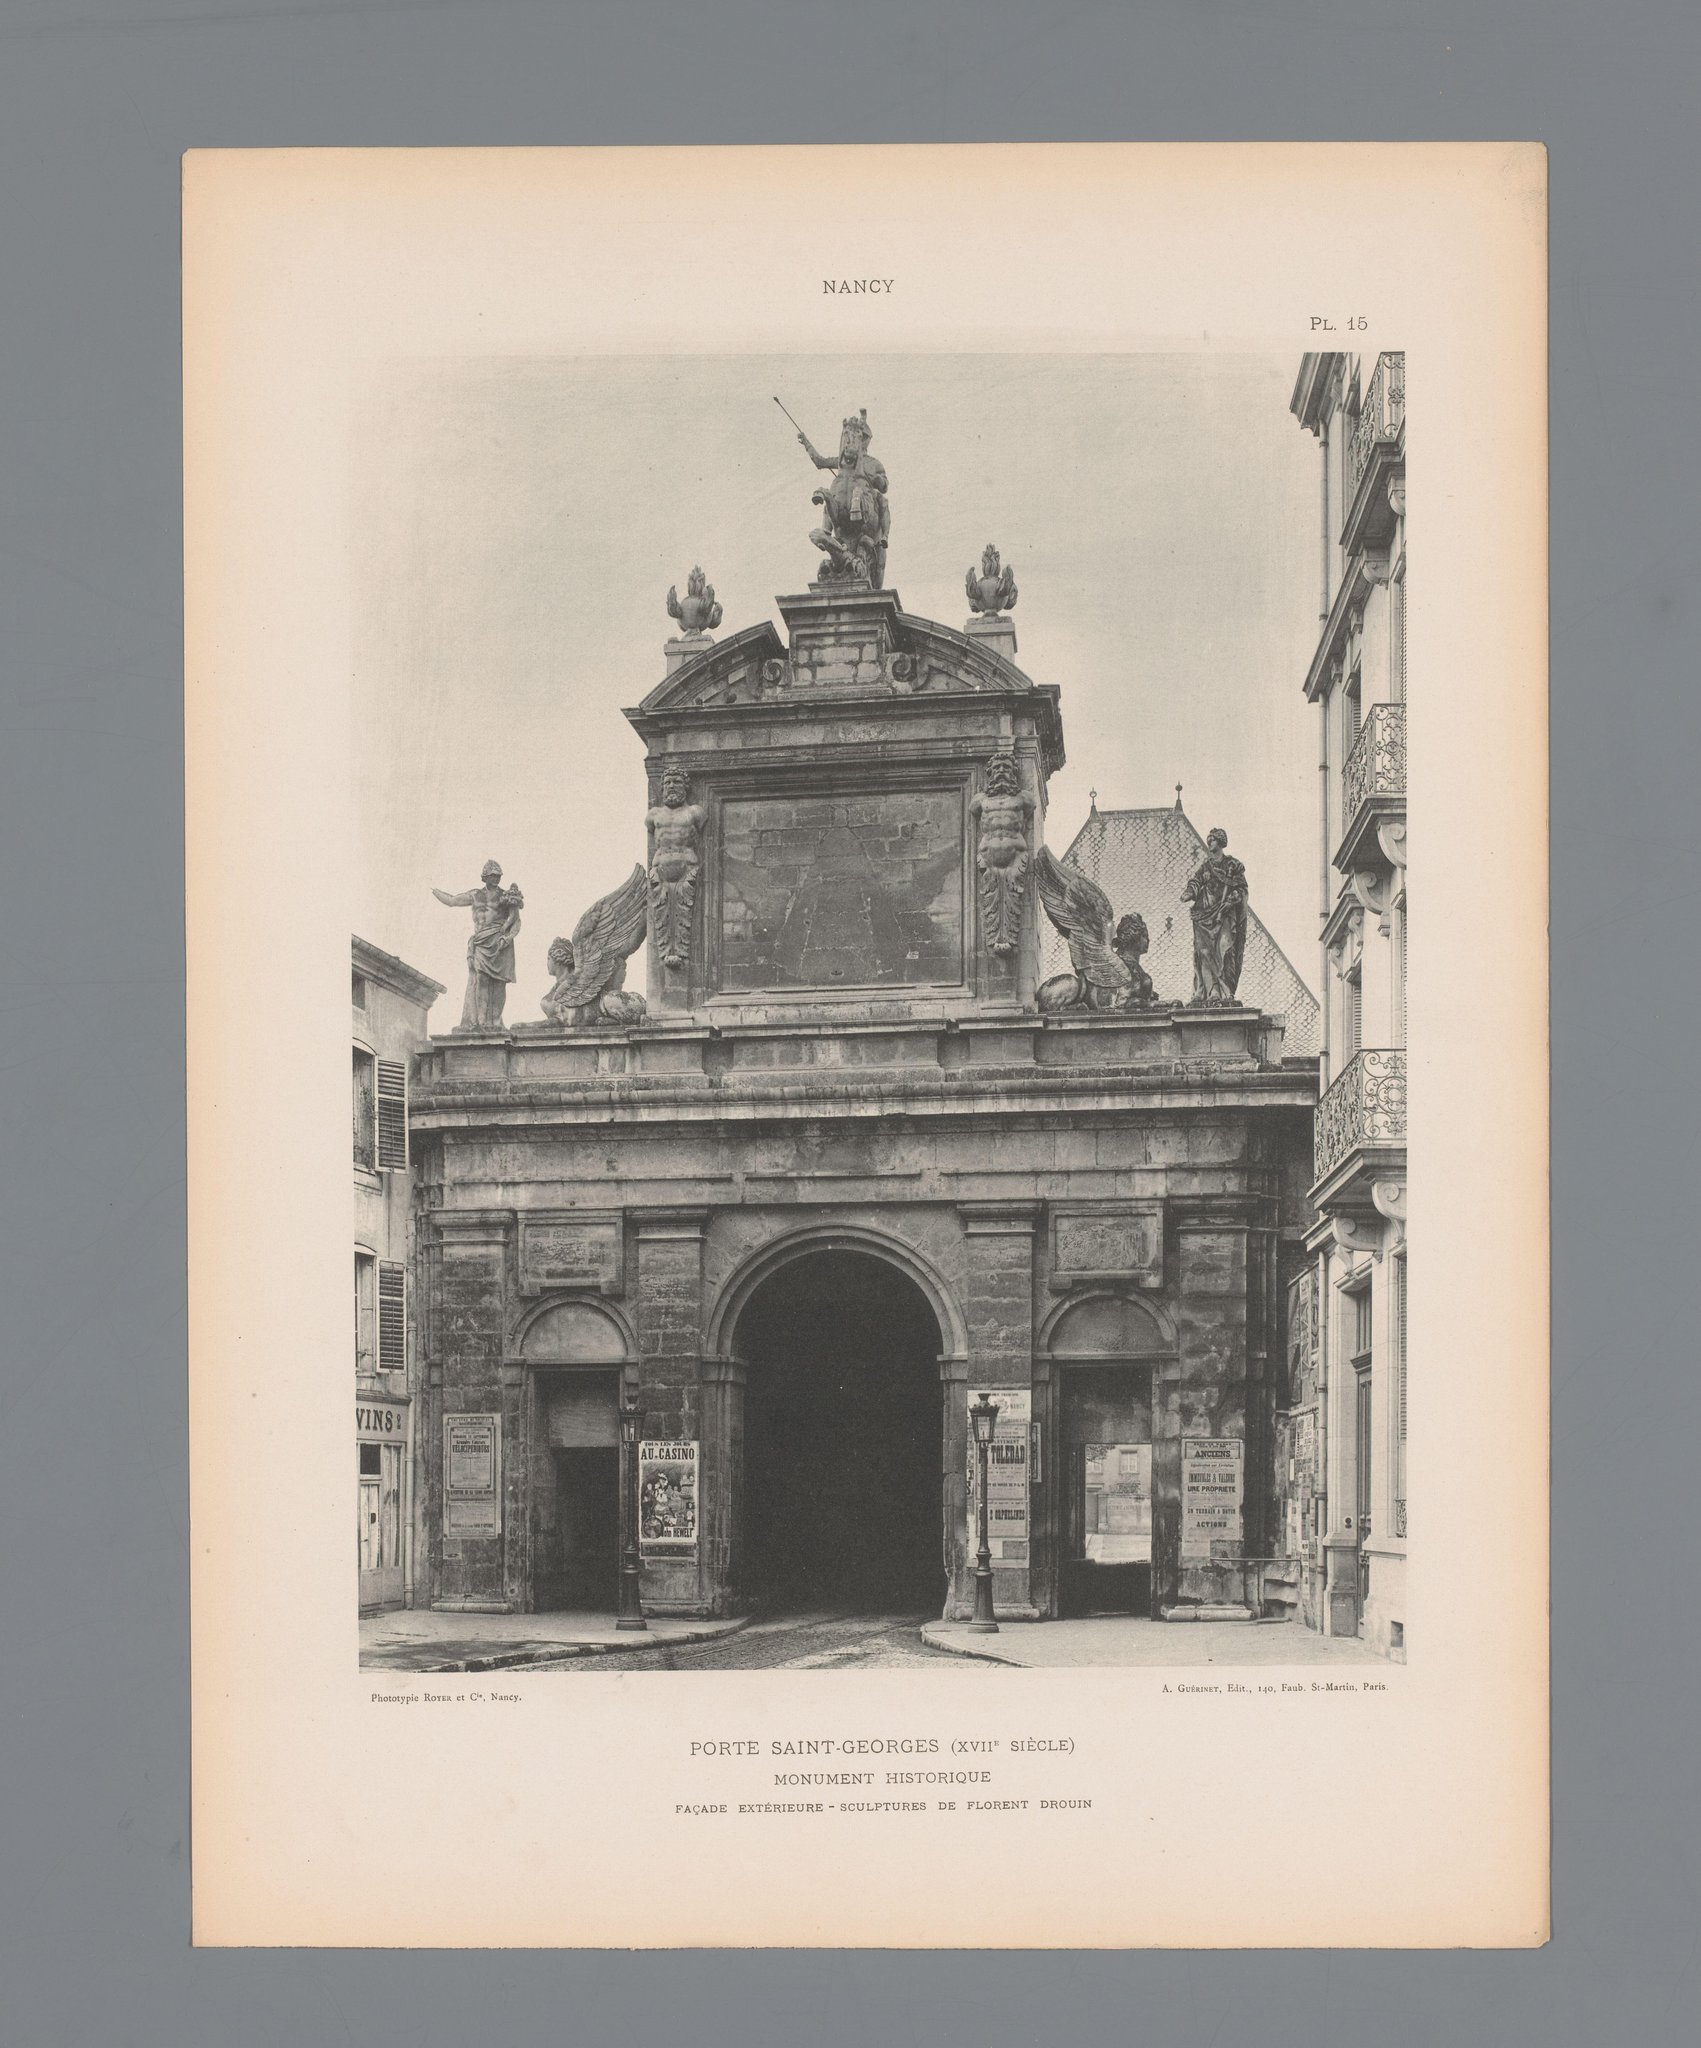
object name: photomechanical print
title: Gezicht op de Porte Saint-Georges te Nancy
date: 1891-1896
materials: paper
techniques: photograph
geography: paris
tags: city-gate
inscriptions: inscription: ‘Porte Saint-Georges (...)’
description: Deze prent maakt deel uit van een omslag met 103 prenten op 101 bladen en een titelblad.